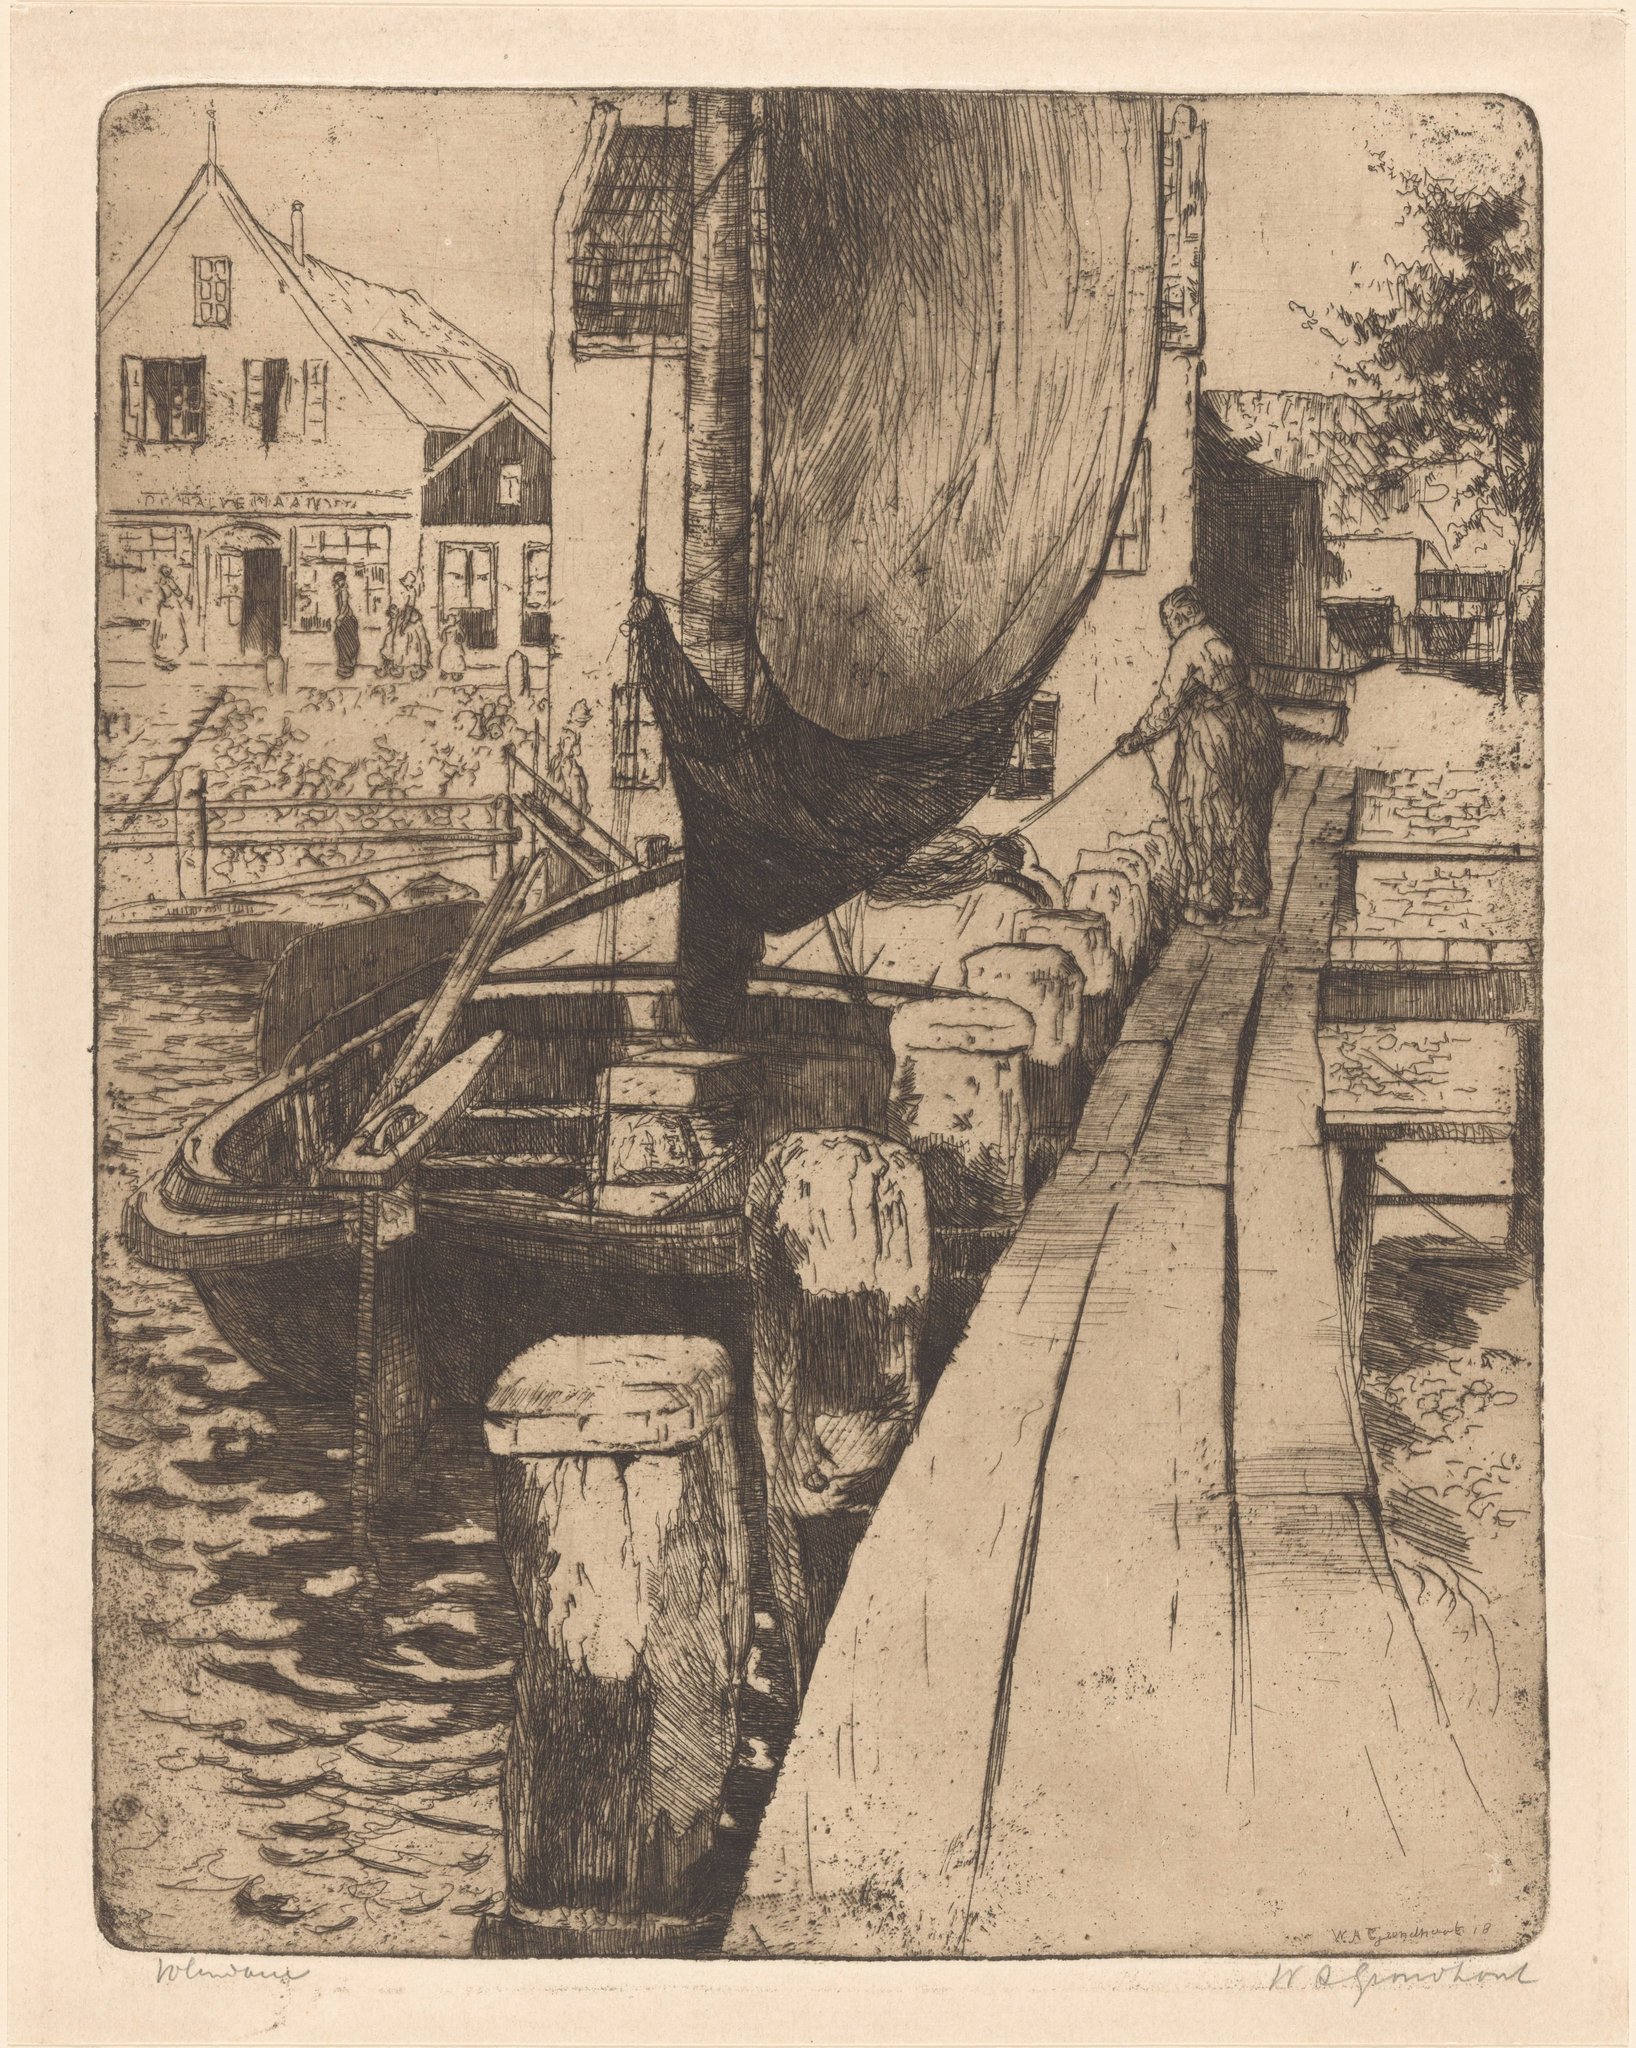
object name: print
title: Volendam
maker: willem adrianus grondhout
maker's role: draughtsman, painter, print maker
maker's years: 1878-1934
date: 1888-1931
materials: paper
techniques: etching, intaglio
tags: harbour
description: Een afgemeerde botter in de haven van Volendam.